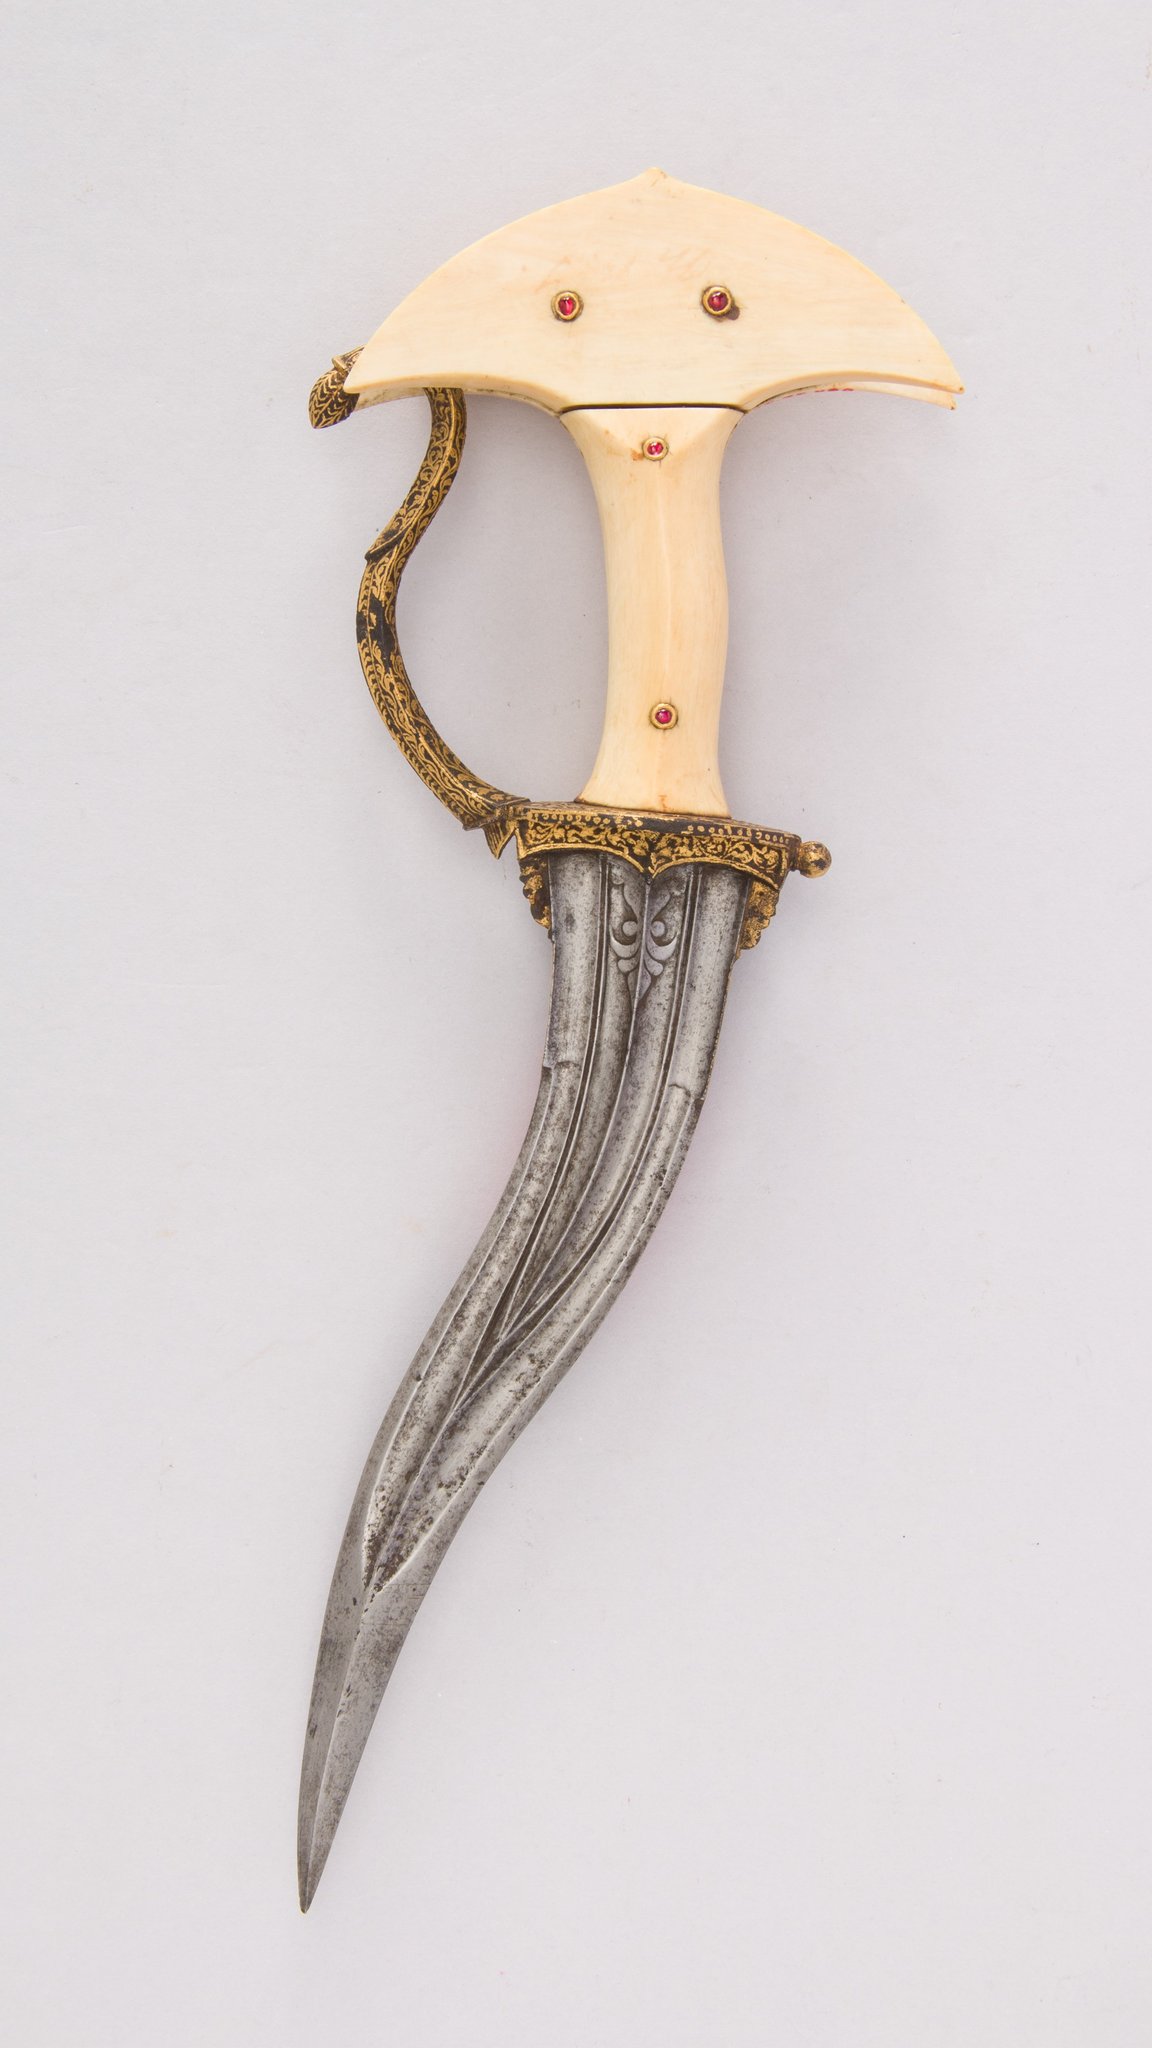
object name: dagger khanjar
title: Dagger (Khanjarli)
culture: south indian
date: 1601-1800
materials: gold, ivory, gemstone, steel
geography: south india